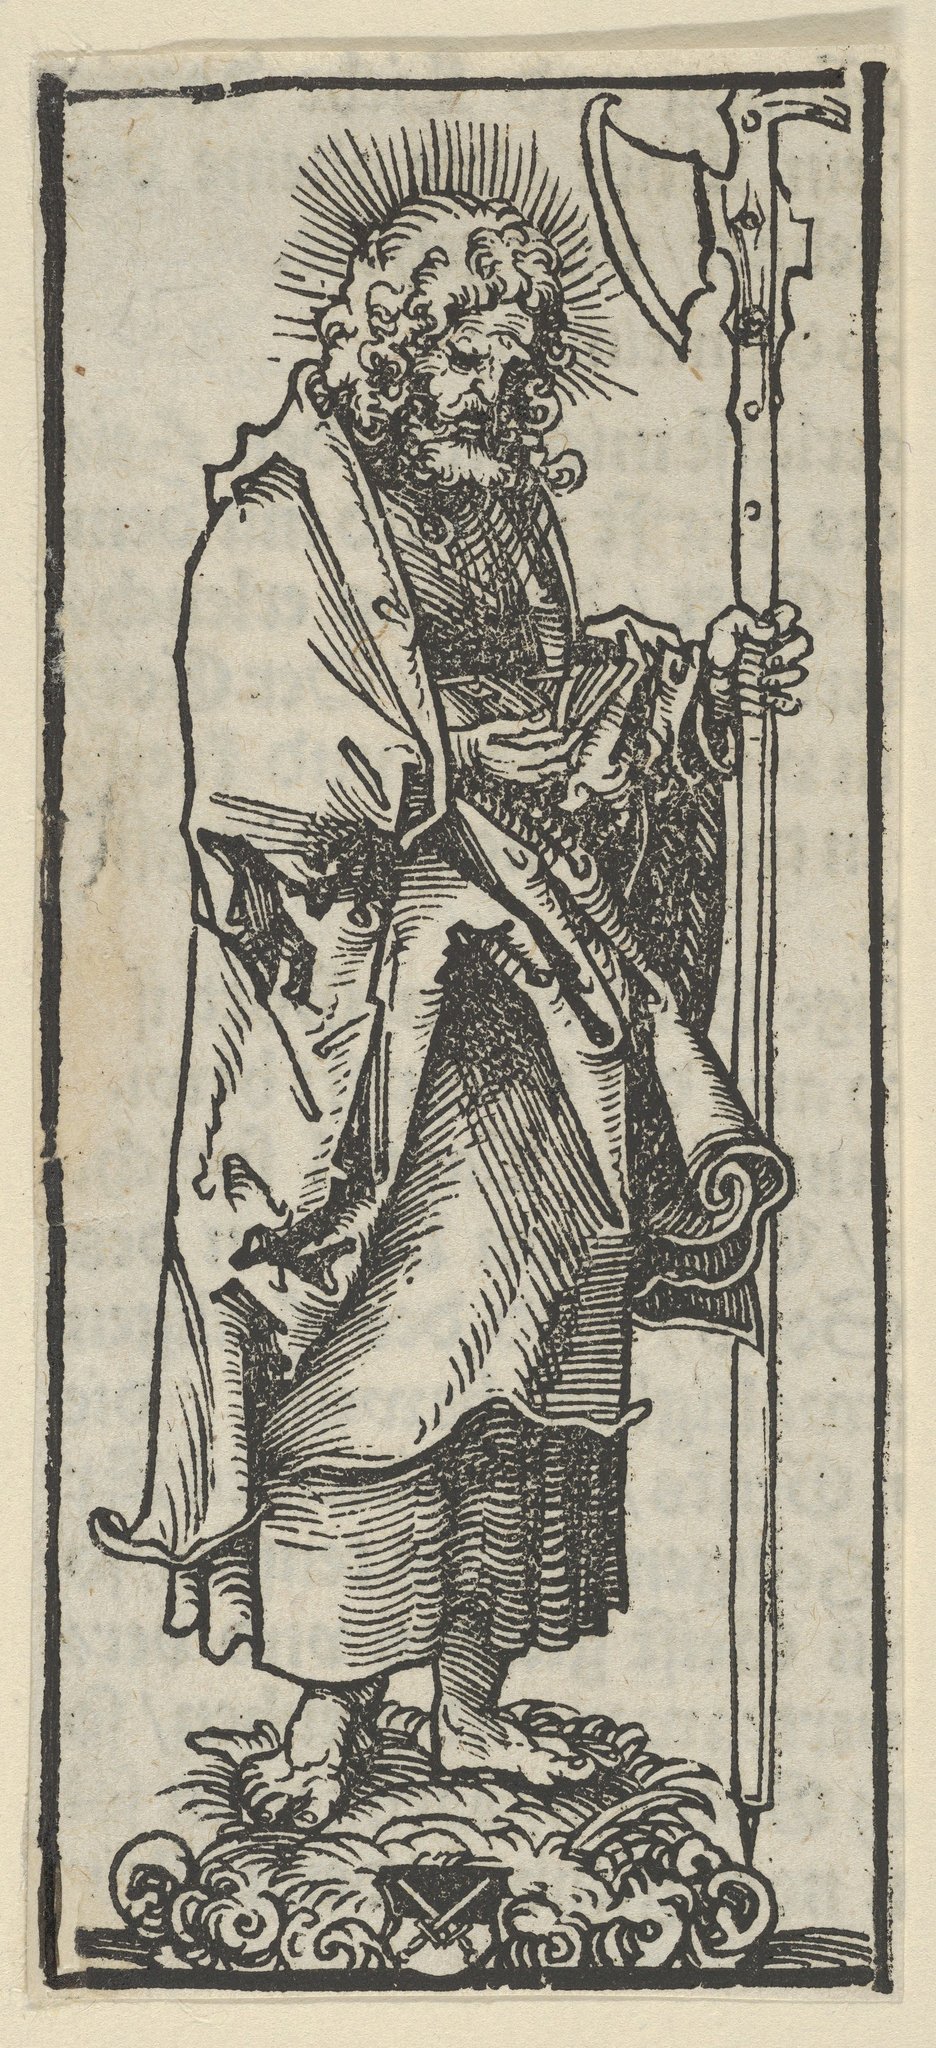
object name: print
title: Silver Statuette of St. Matthew from the Wittenberg Reliquaries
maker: lucas cranach the elder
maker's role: artist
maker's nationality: german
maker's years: 1472-1553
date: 1472-1553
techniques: woodcut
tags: saint matthew